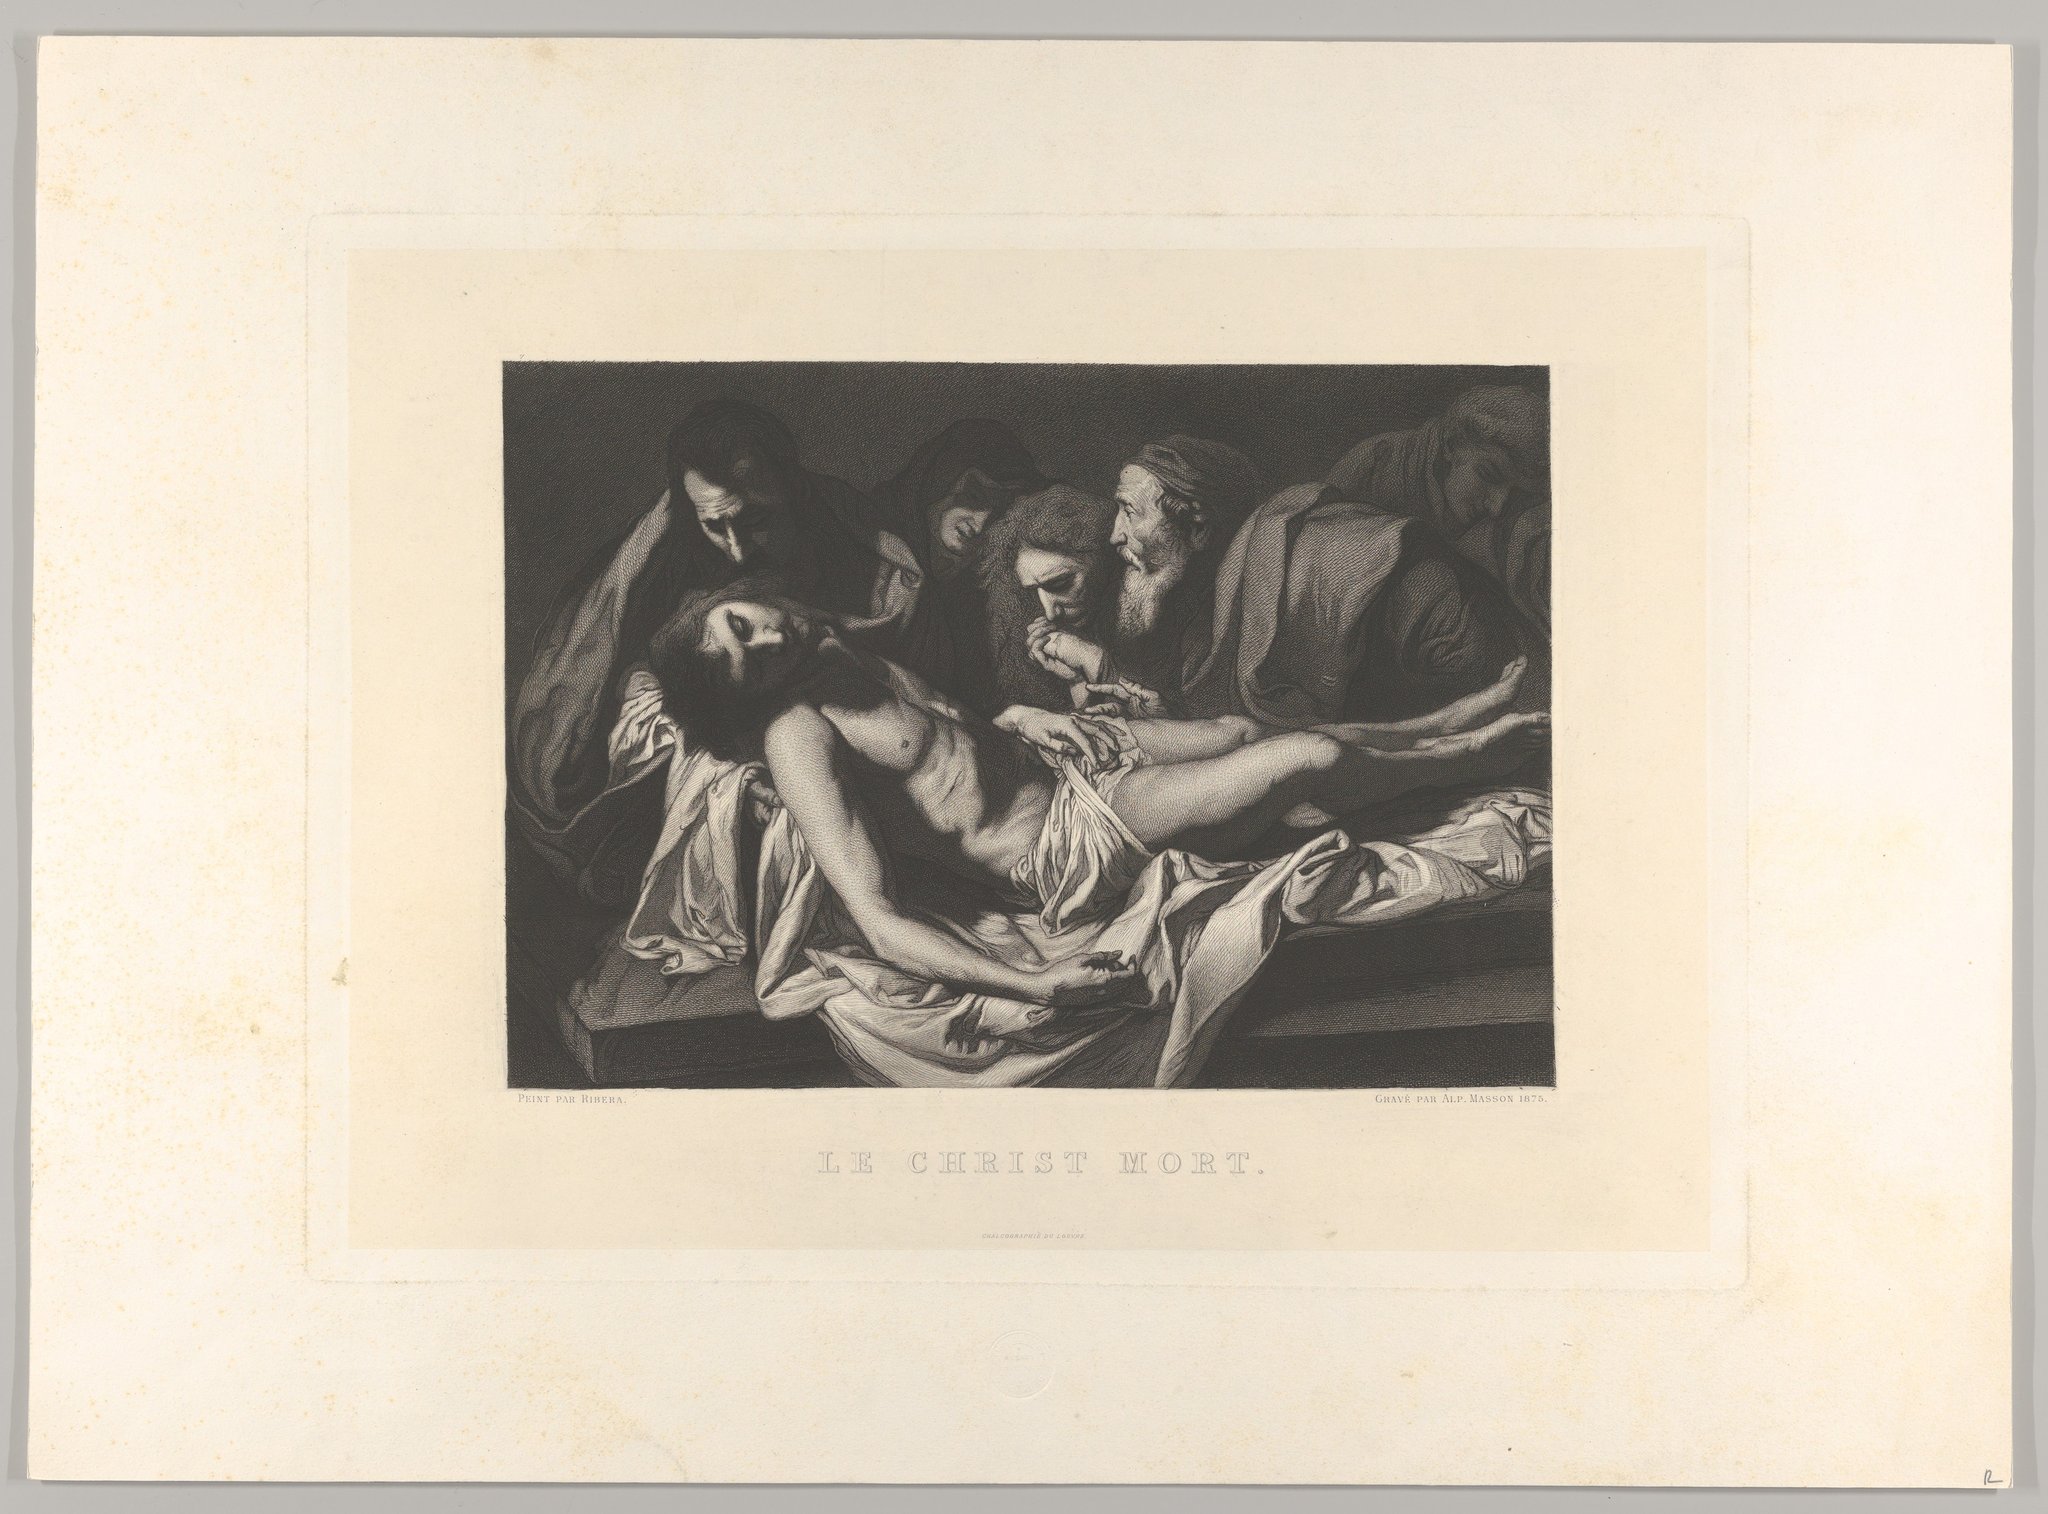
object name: print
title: The Lamentation Over the Dead Christ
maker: alphonse-charles masson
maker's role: artist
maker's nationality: french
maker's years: 1814-1898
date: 1875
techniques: printmaking, drypoint, etching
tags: men,christ,lamentation